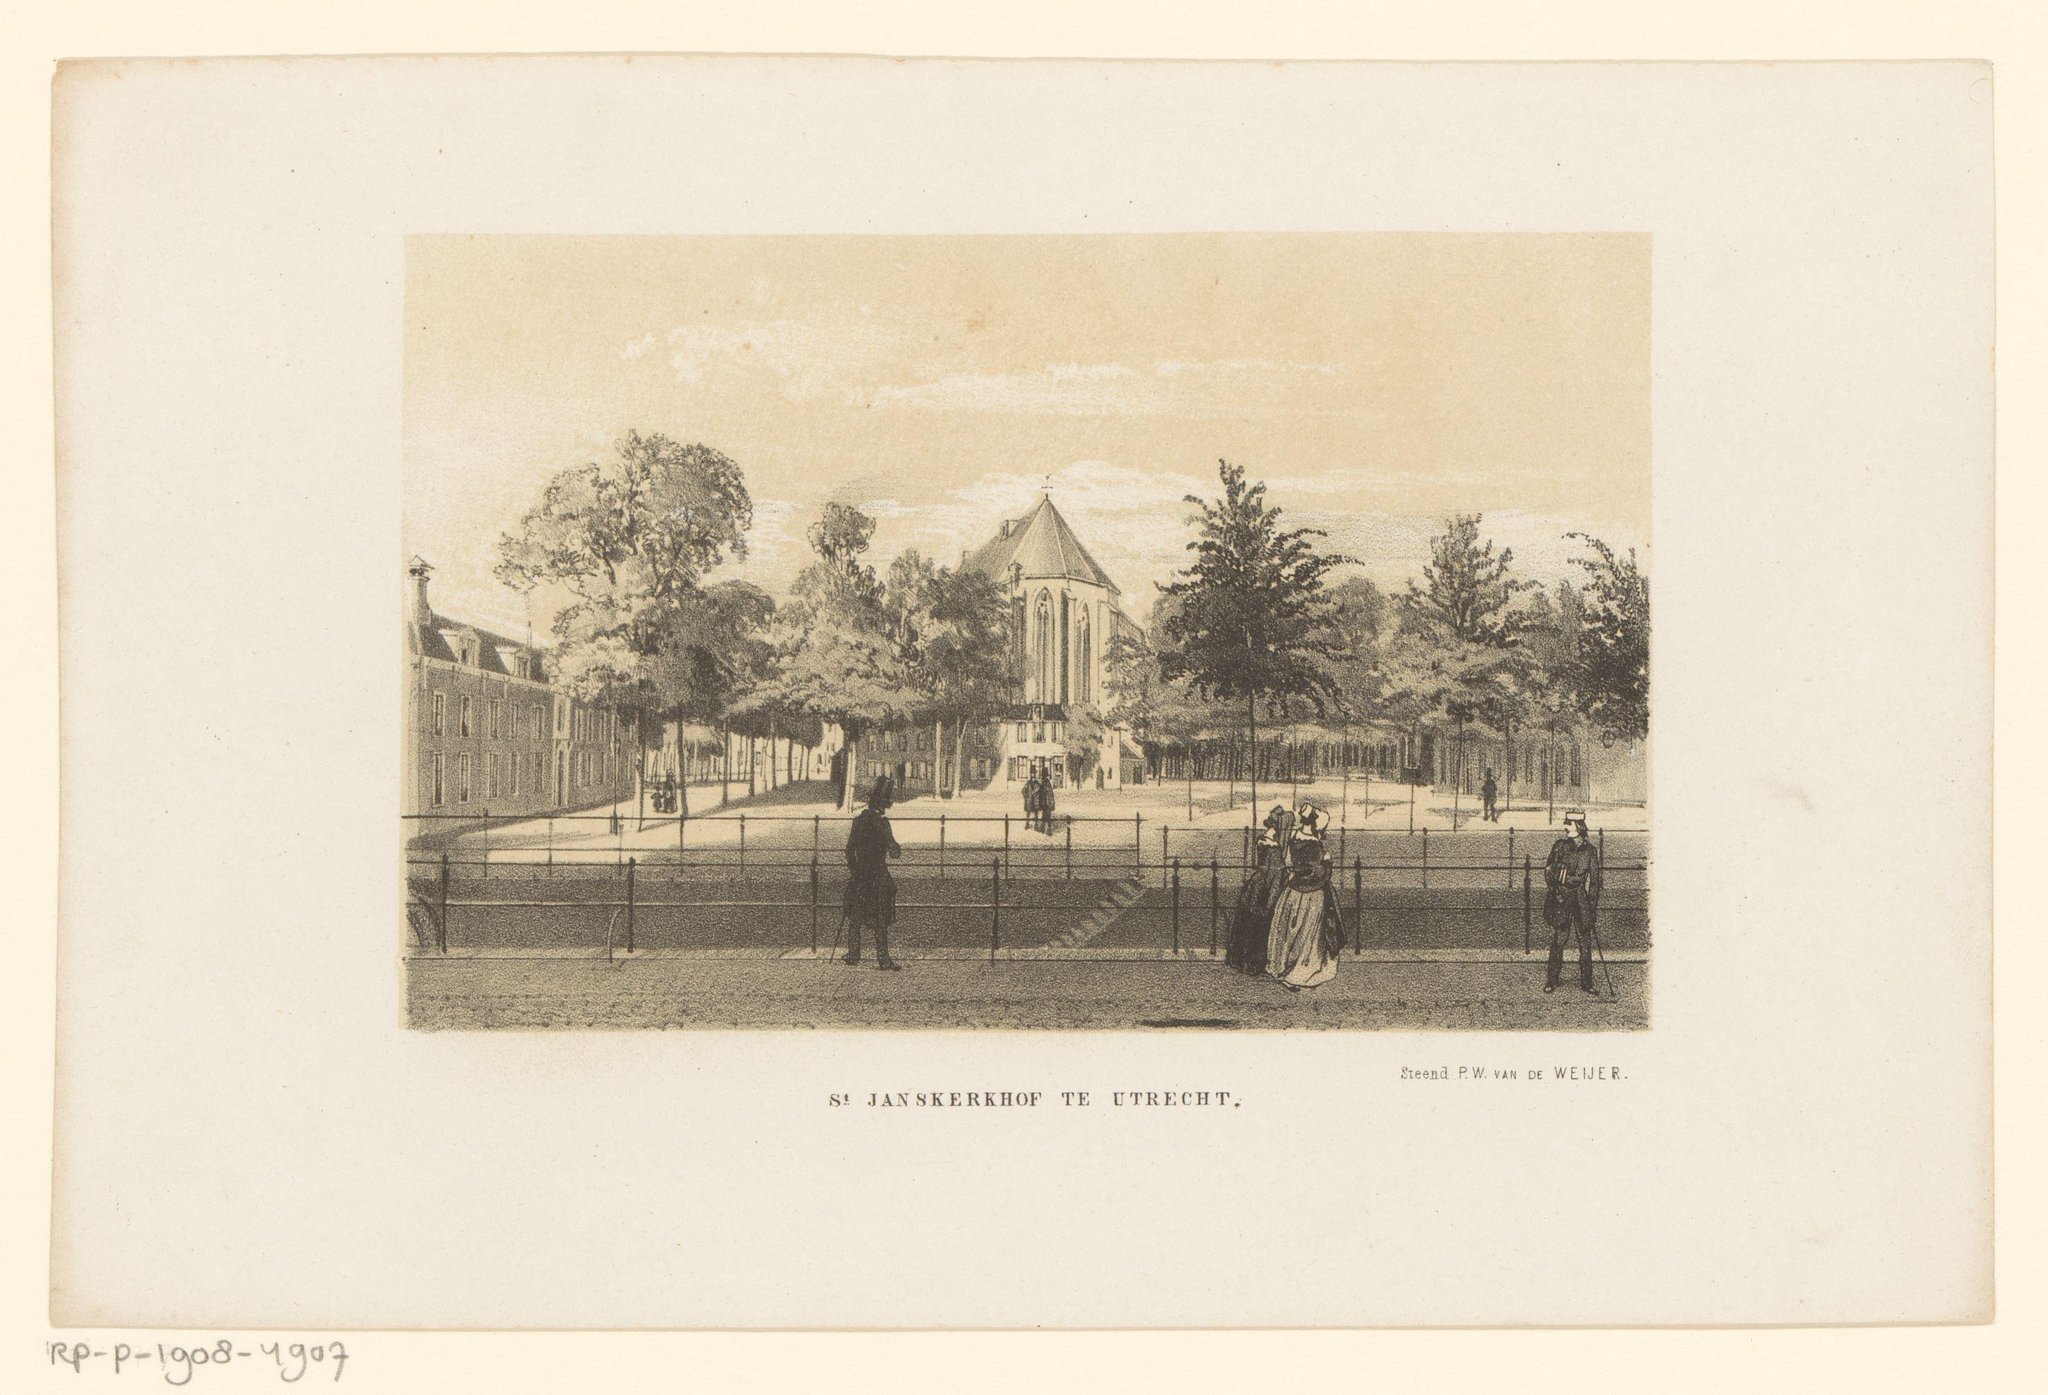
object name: print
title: St. Janskerkhof te Utrecht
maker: pieter wilhelmus van de weijer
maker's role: print maker, printer, publisher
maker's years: 1816-1880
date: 1856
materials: paper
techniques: tone lithography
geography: utrecht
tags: city-view, and landscape with man-made constructions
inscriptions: collector's mark: Lugt 2228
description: Blik op het koor van de St. Janskerk en het St. Janskerkhof vanaf de overzijde van de Drift.